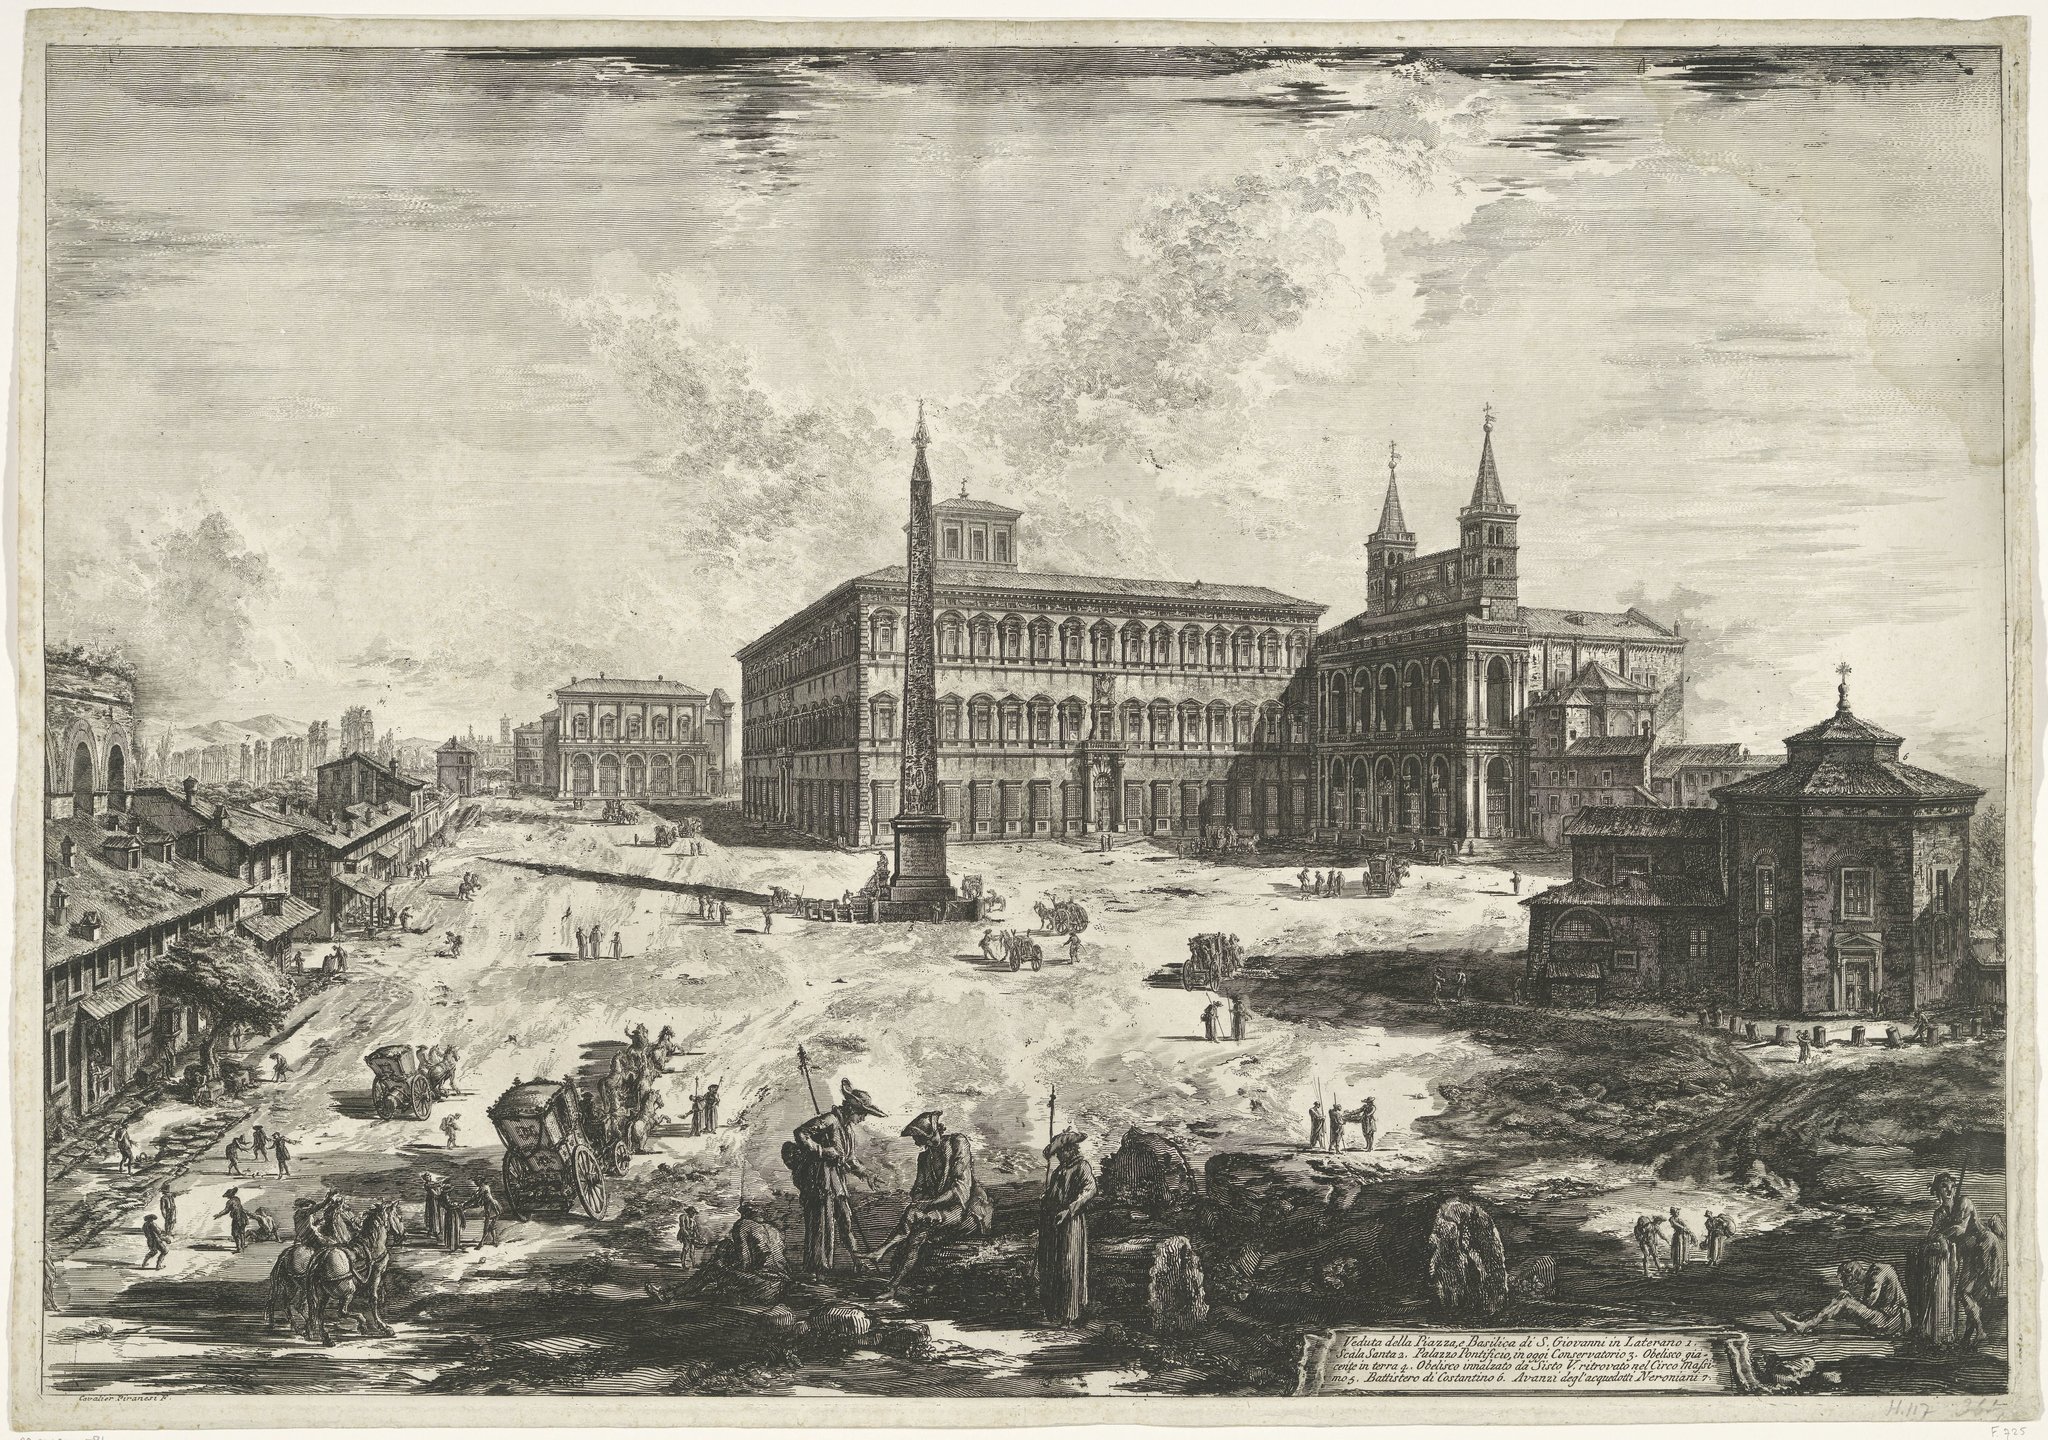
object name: print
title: Gezicht op het Lateraan te Rome met de Sint-Jan van Lateranen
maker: giovanni battista piranesi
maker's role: designer, draughtsman, print maker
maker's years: 1720-1778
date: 1748-1778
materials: paper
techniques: etching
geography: rome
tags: square, place, circus, etc., obelisk, needle, church (exterior), roman catholic church, hôtel, i.e. small palace in city, rome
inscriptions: collector's mark: Lugt 2228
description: Gezicht op het Lateraan te Rome met de Heilige Trap (Scala Sancta), de achterzijde van de basiliek van Sint-Jan van Lateranen, het Lateraans Paleis, het Baptisterium van Lateranen en de Lateraanse Obelisk. Titels en verklarende lijst met nummers op banderol rechtsonder.